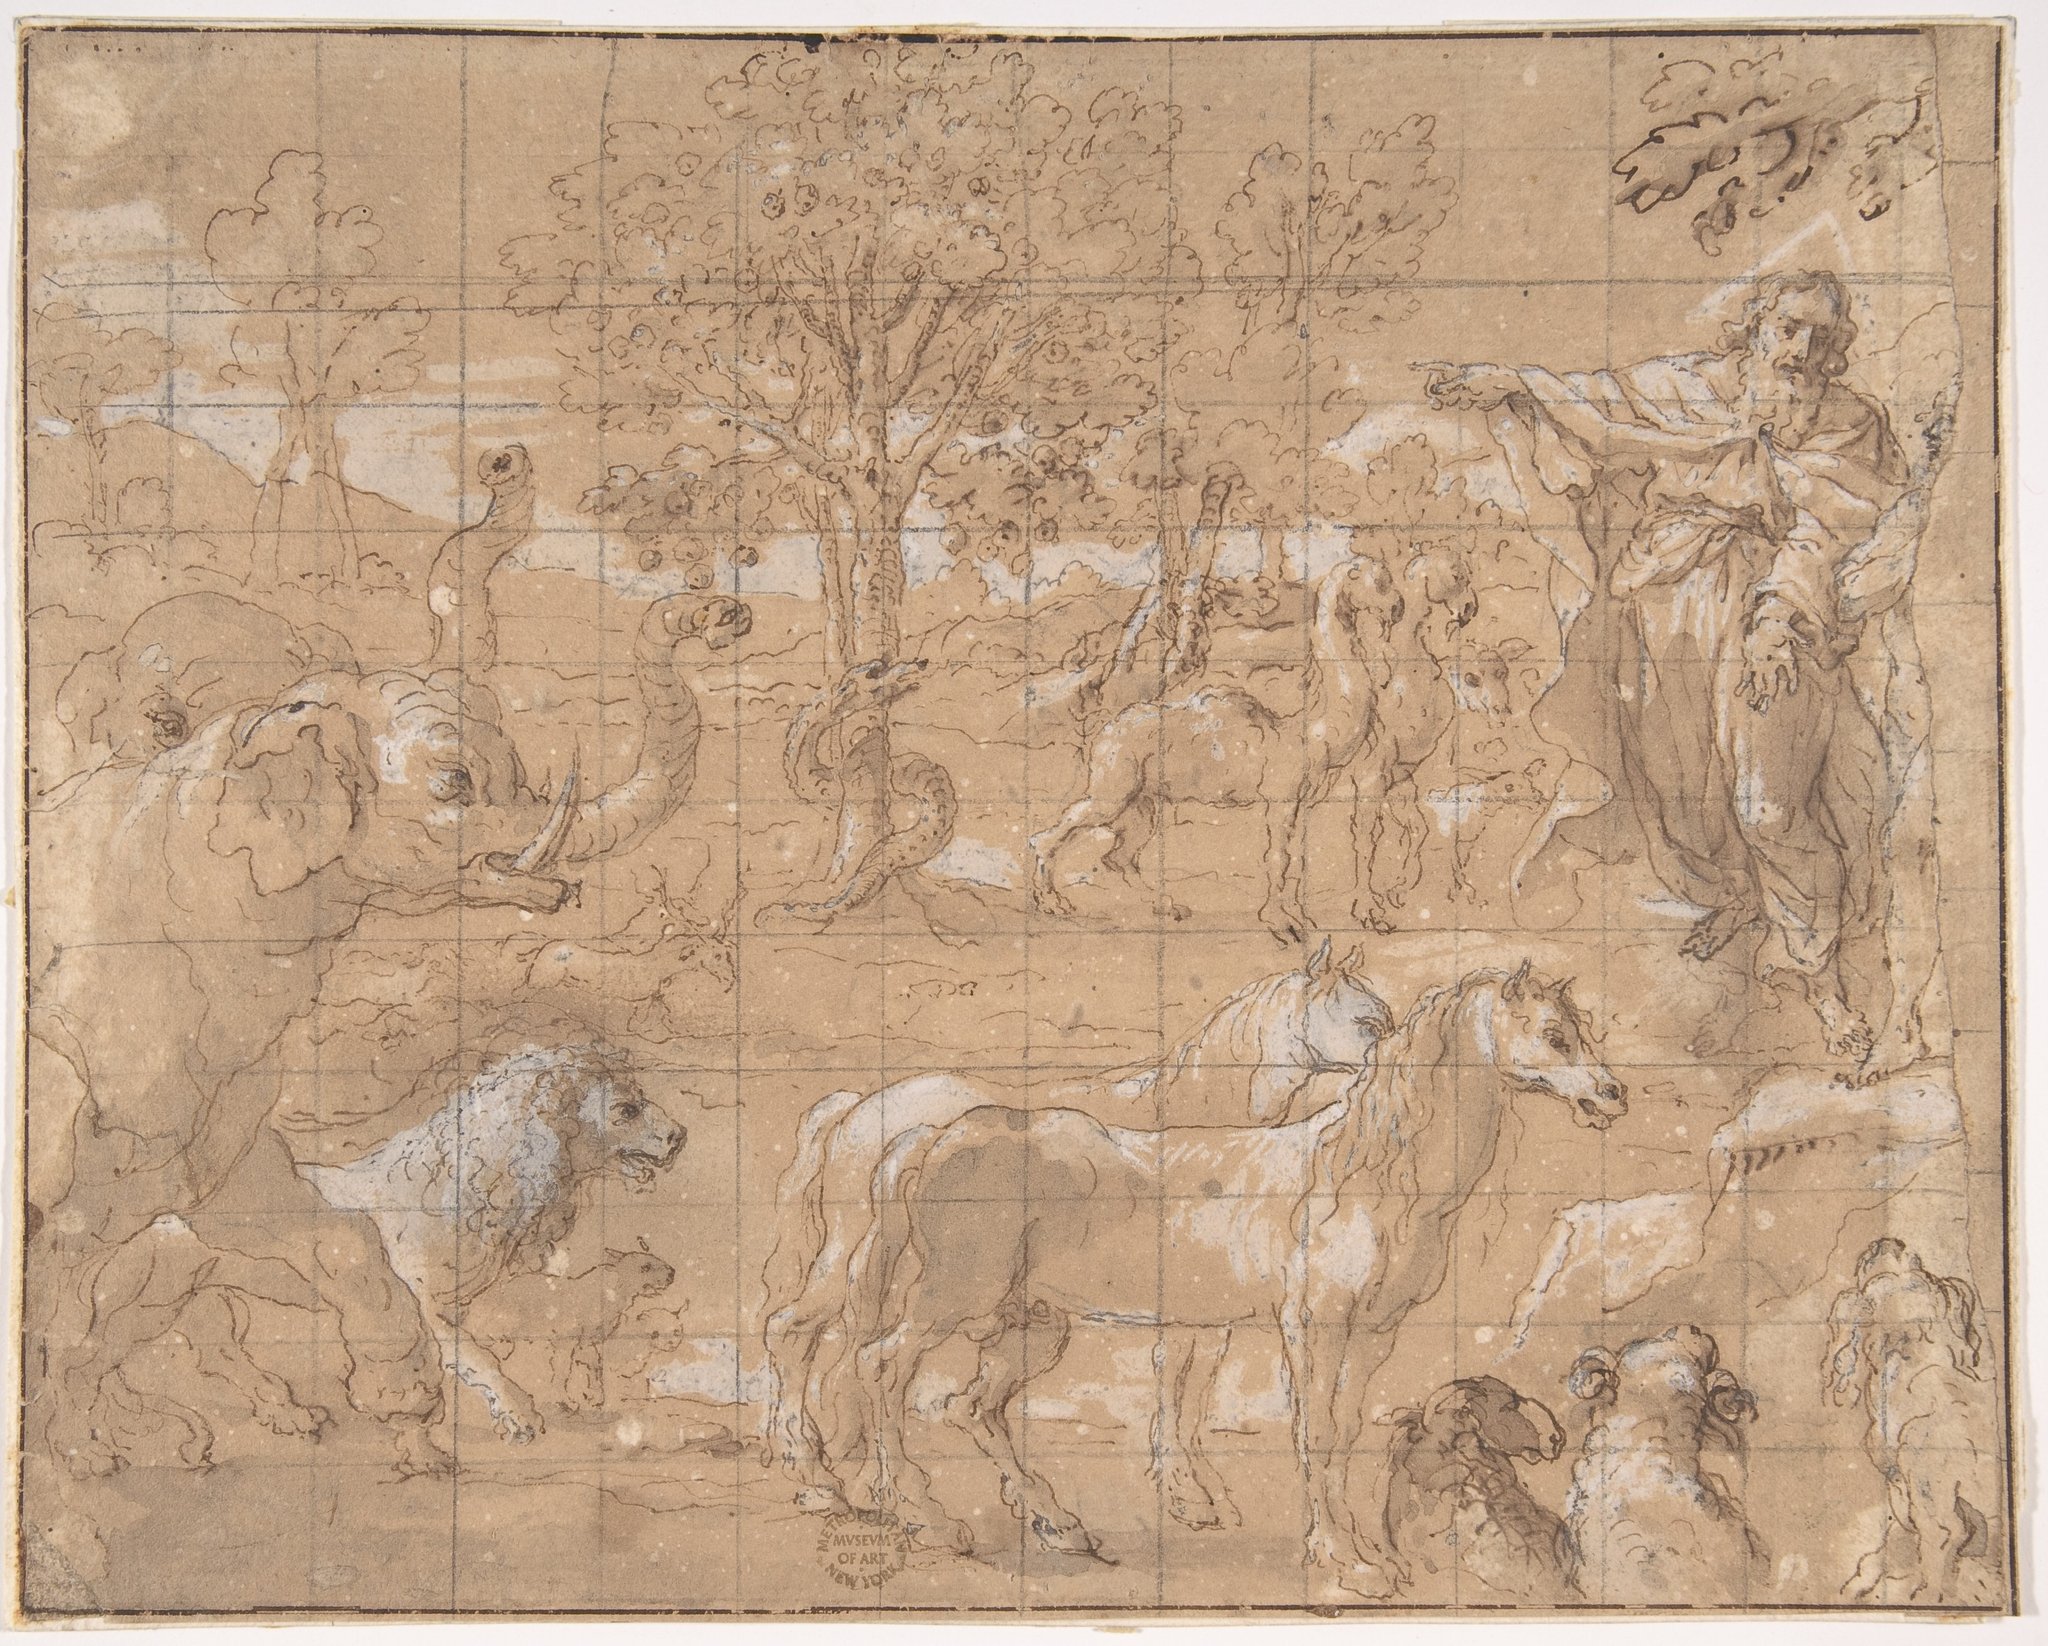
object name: drawing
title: Garden of Eden; Creation of the Animals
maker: anonymous, netherlandish, 16th century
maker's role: artist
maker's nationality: netherlandish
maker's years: 1500-1600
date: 1501-1600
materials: gouache, paper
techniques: highlighting, pen, drawing, wash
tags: gardens,elephants,horses,snakes,trees